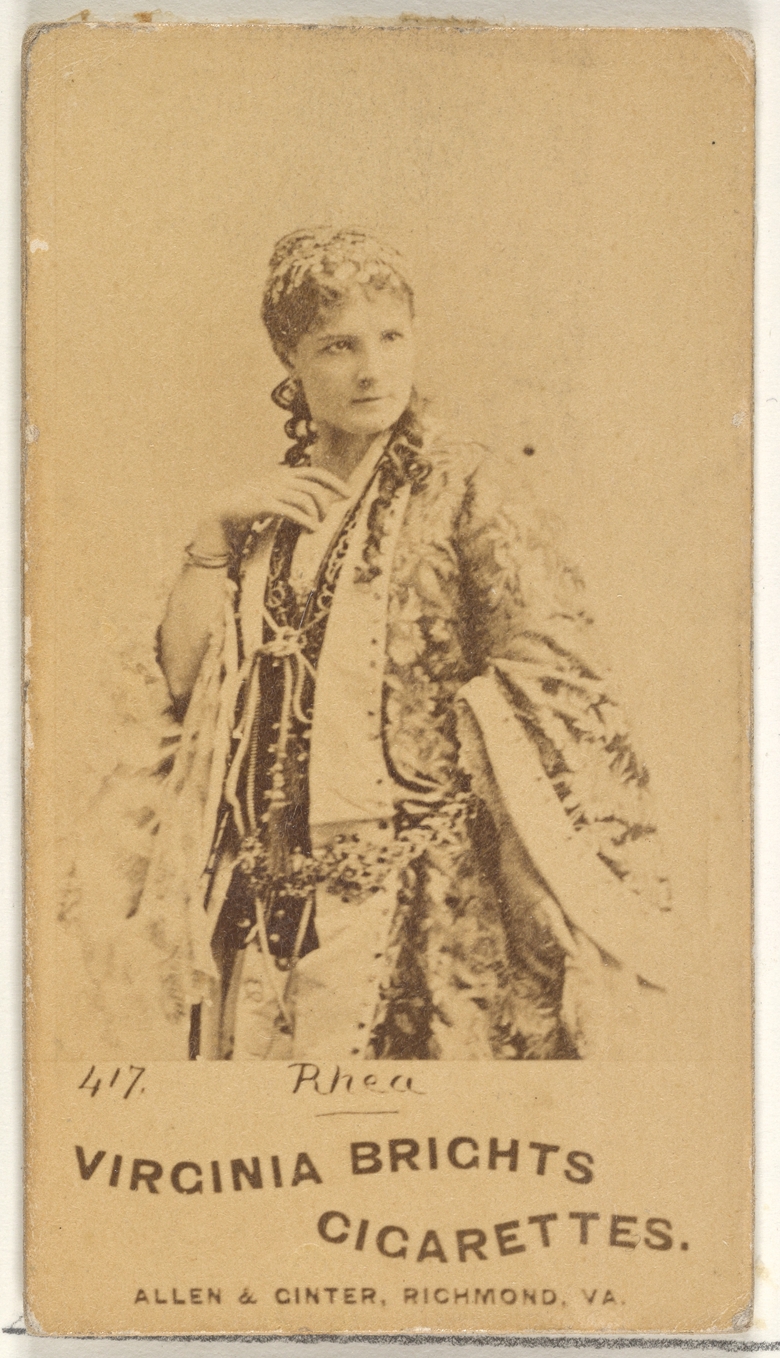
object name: photograph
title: Card 417, Rhea, from the Actors and Actresses series (N45, Type 1) for Virginia Brights Cigarettes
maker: allen & ginter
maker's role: publisher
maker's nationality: american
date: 1888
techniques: albumen silver print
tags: portraits,women,actresses